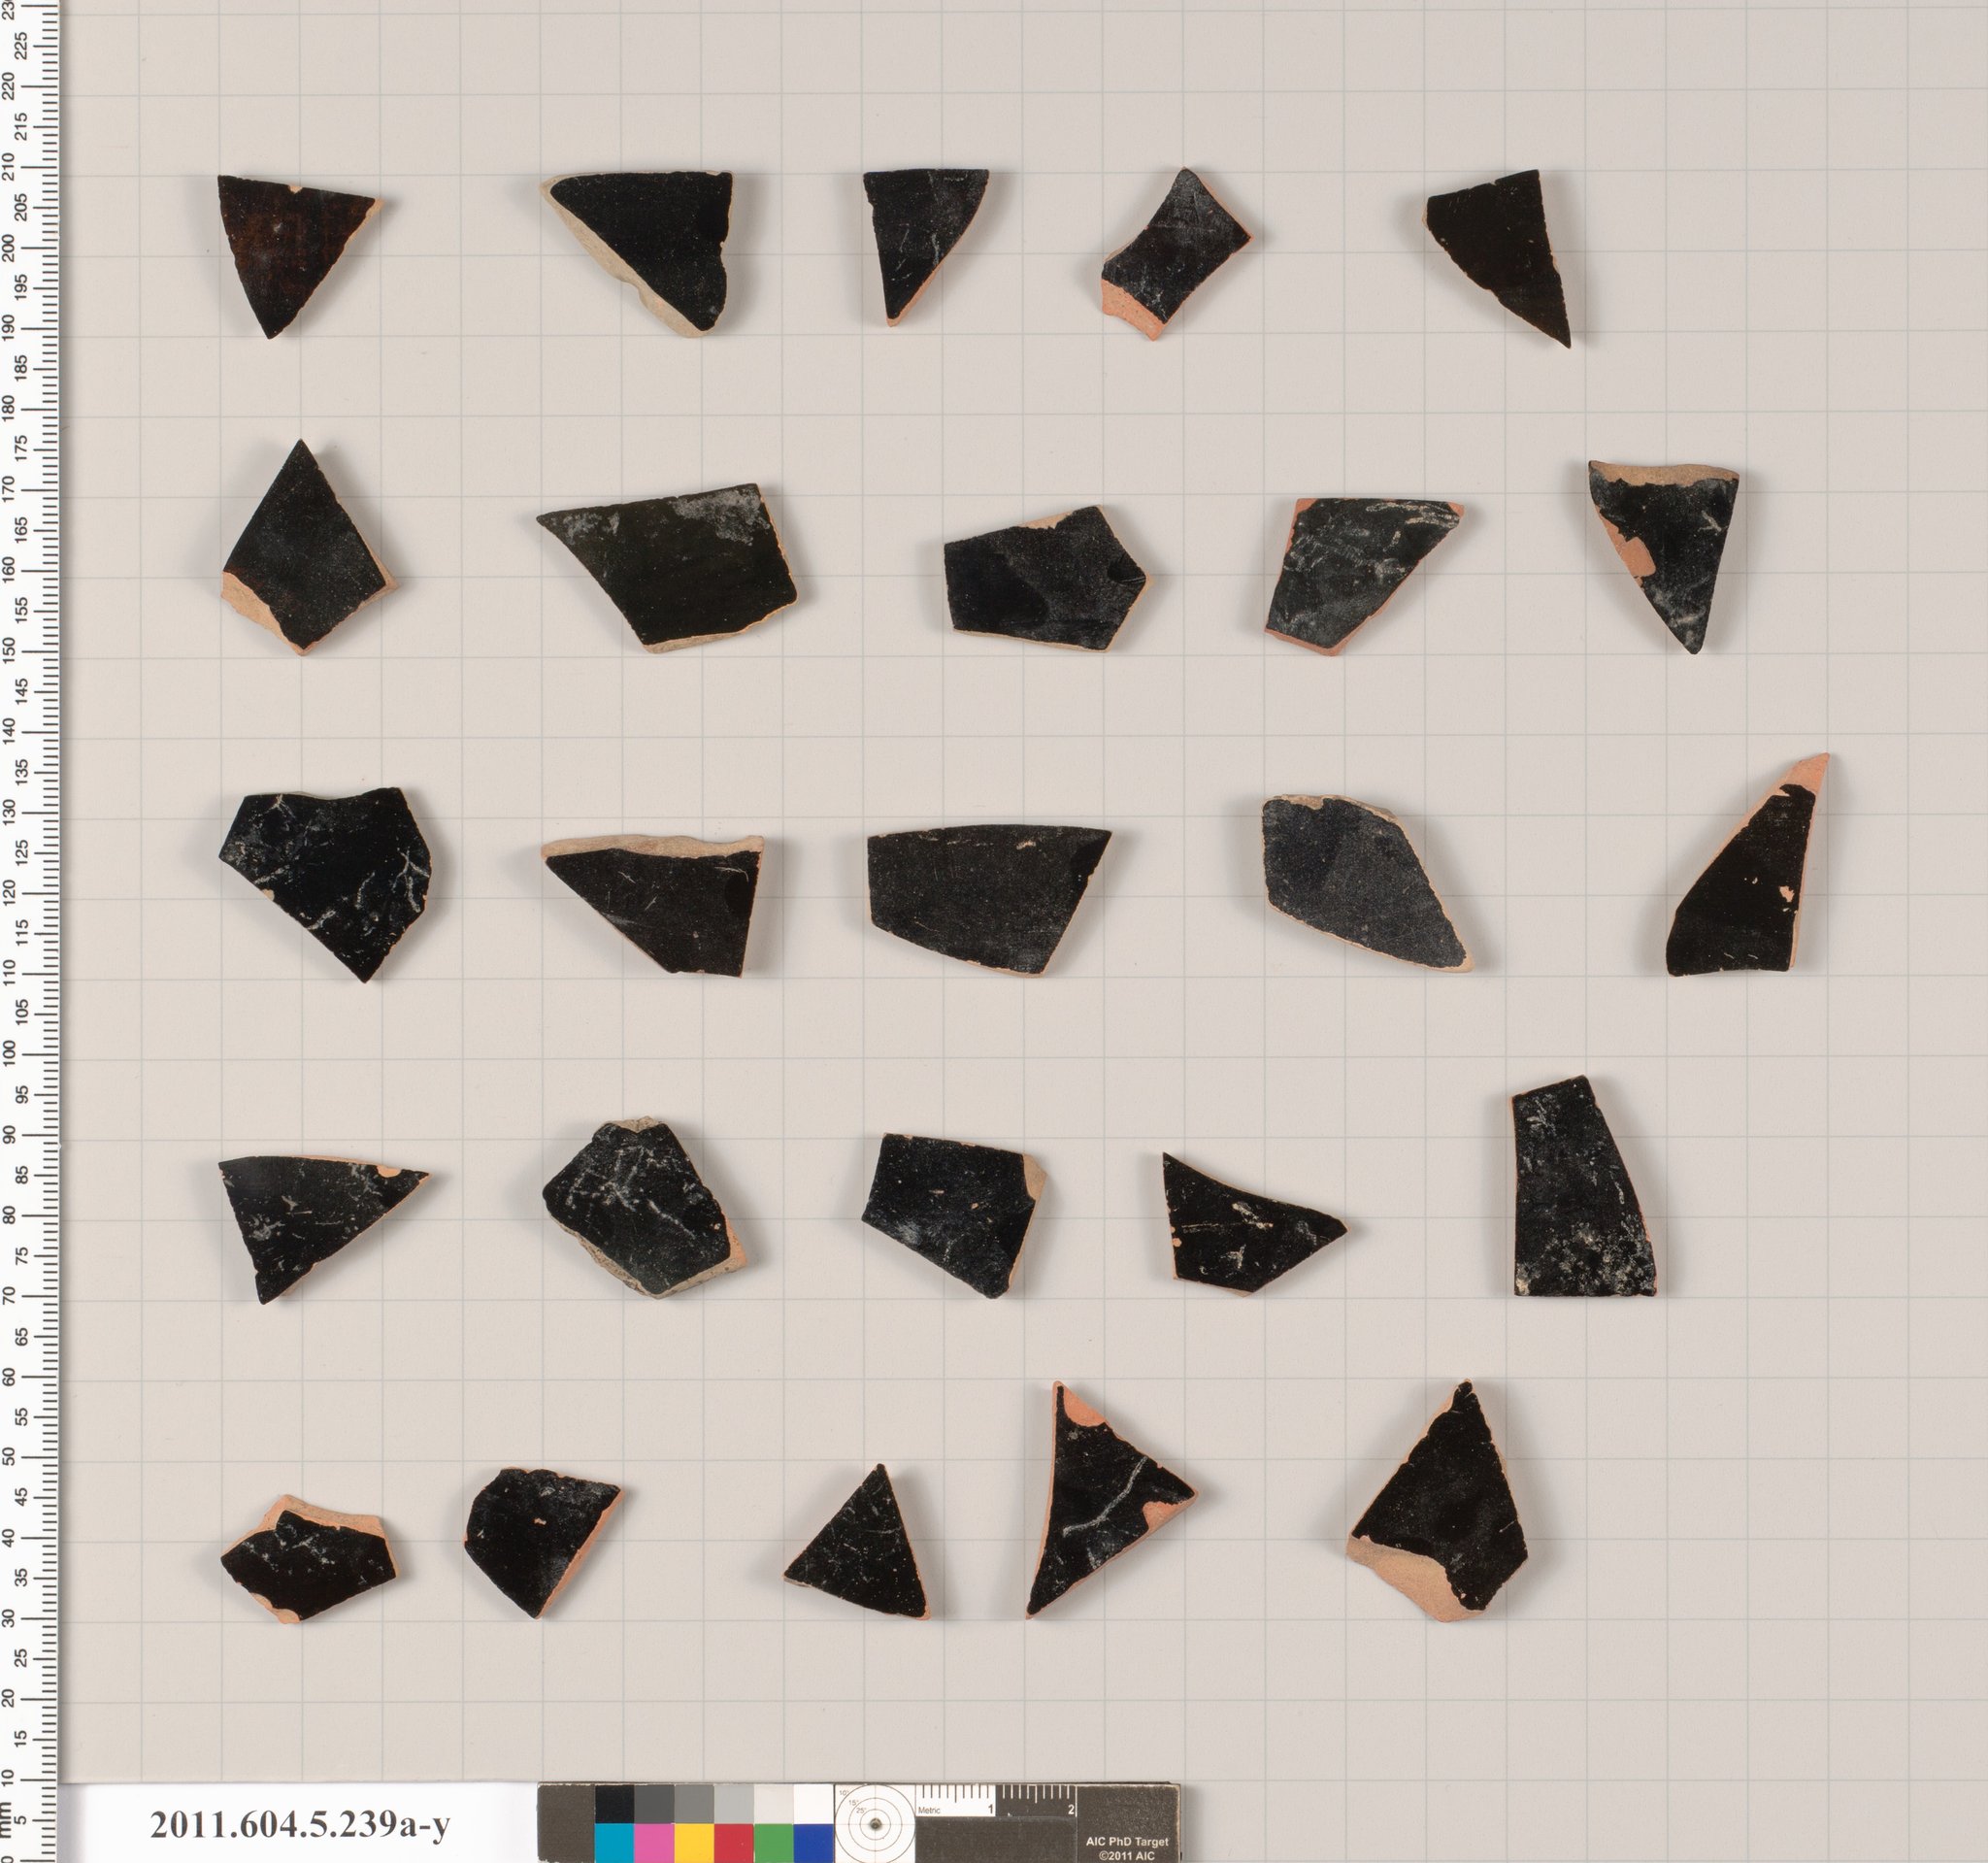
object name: kylix fragment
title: Terracotta fragments of kylikes (drinking cups)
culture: greek, attic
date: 600-401 BCE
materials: terracotta